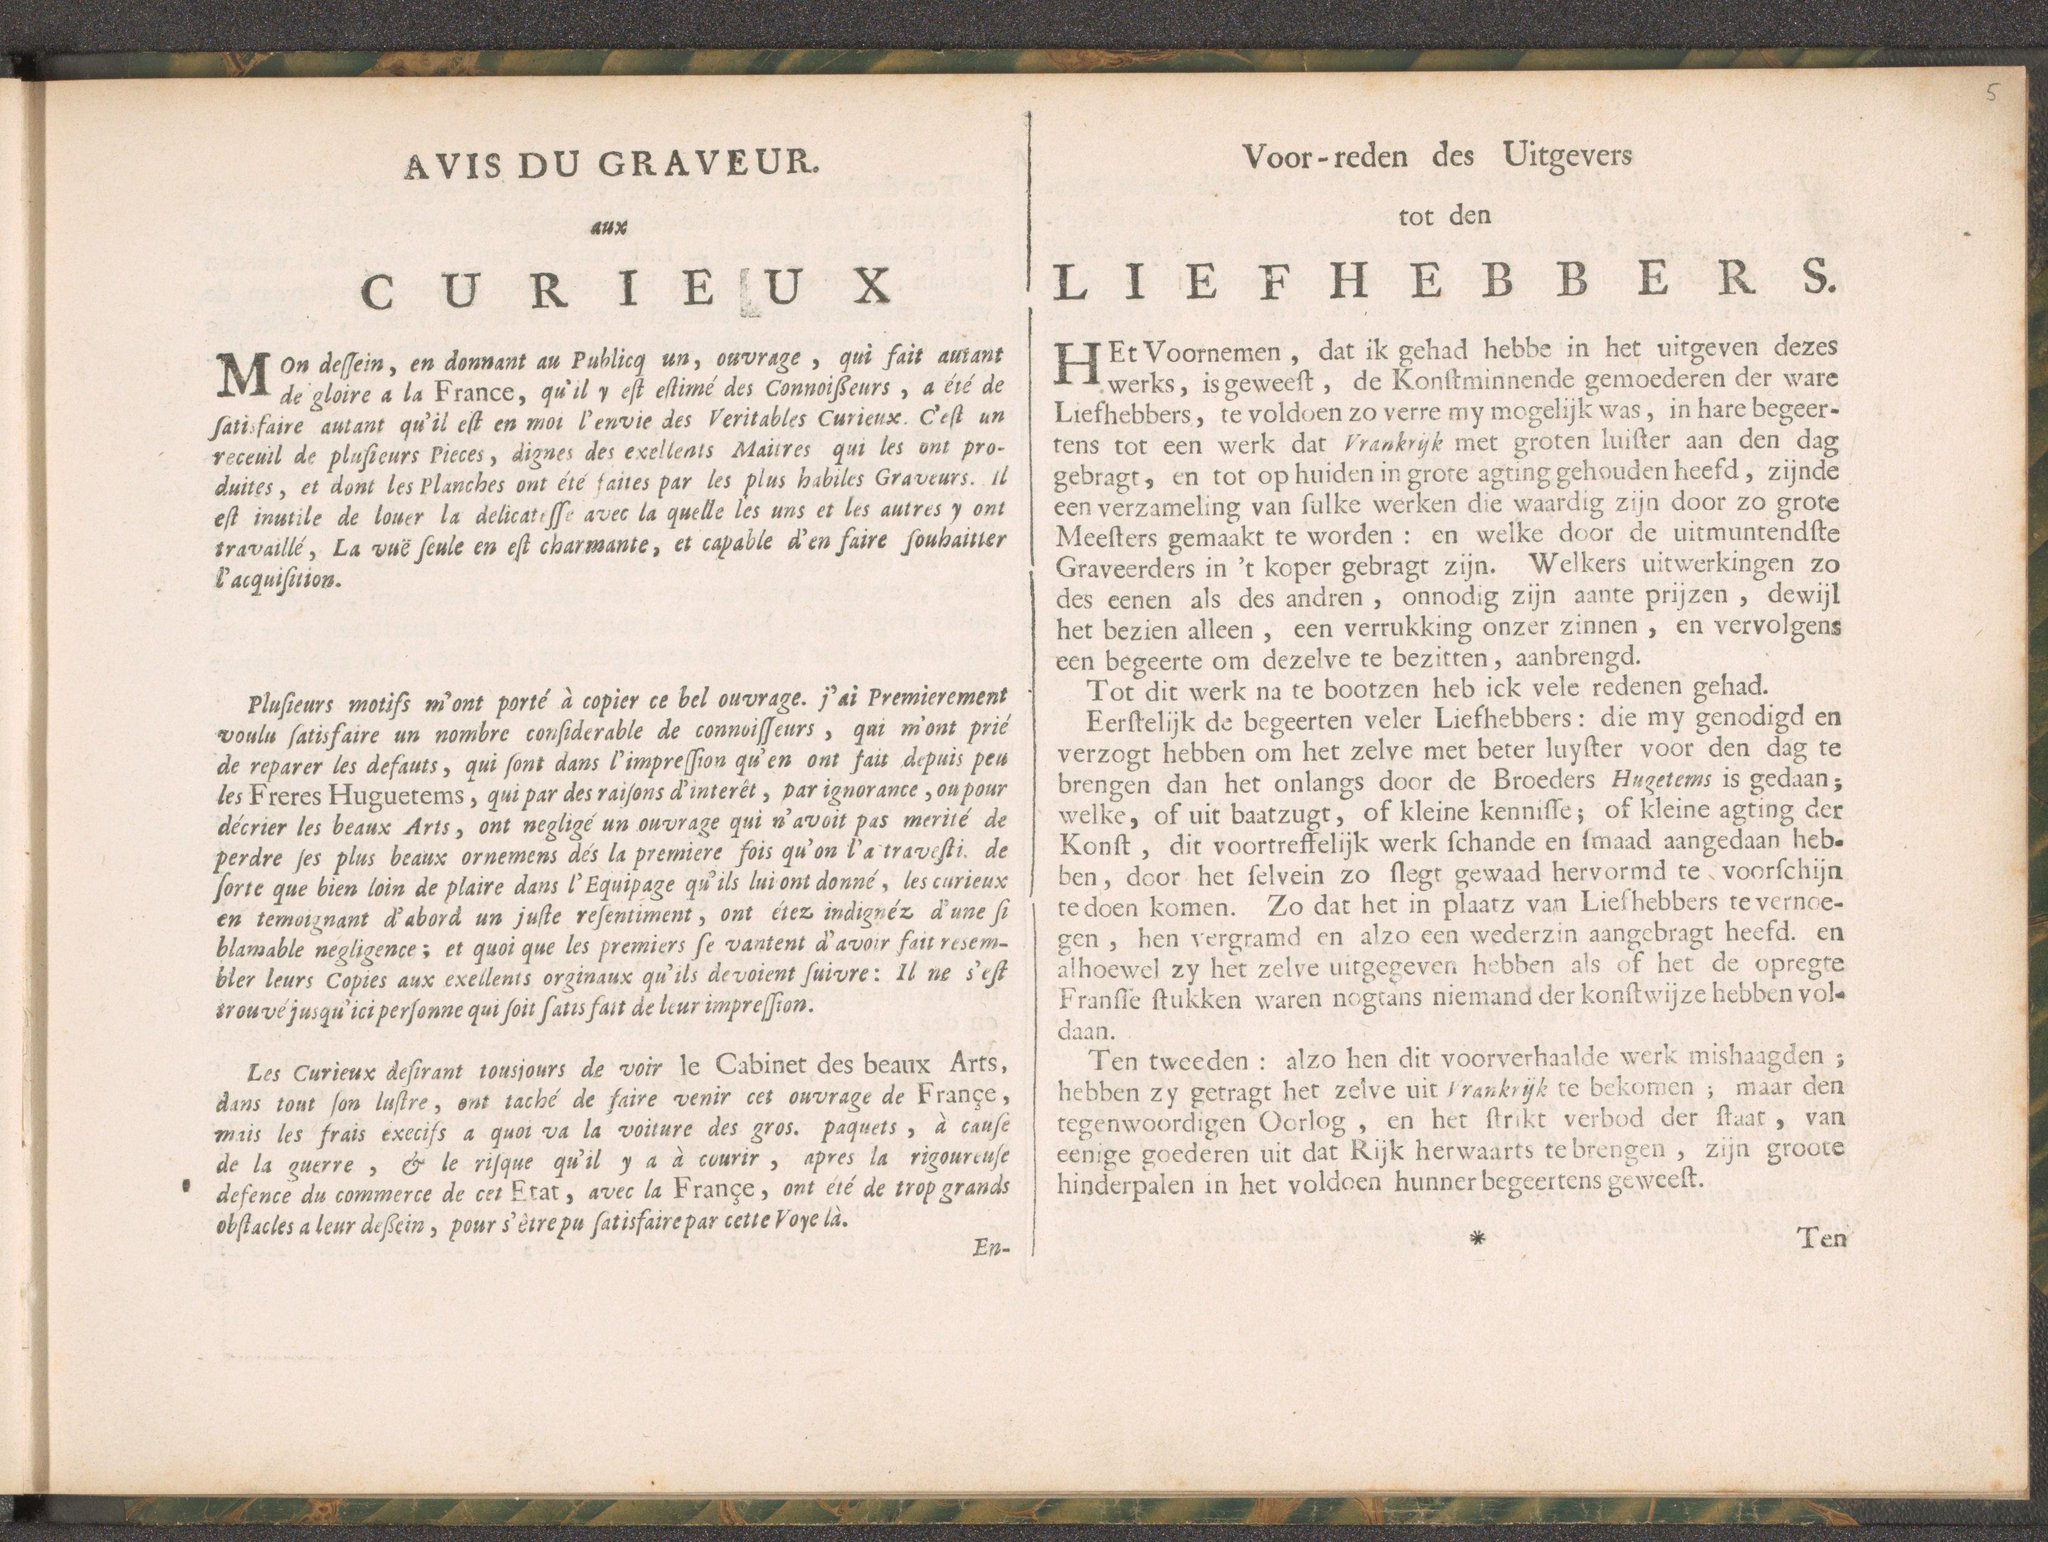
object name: text sheet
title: Avis du Graveur aux Curieux / Voor-reden des Uitgevers tot den Liefhebbers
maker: pieter schenk (i)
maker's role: print maker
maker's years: 1660-1711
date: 1693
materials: paper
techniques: letterpress printing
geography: amsterdam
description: Voorwoord van de uitgever. Tekstblad maakt deel uit van een album.